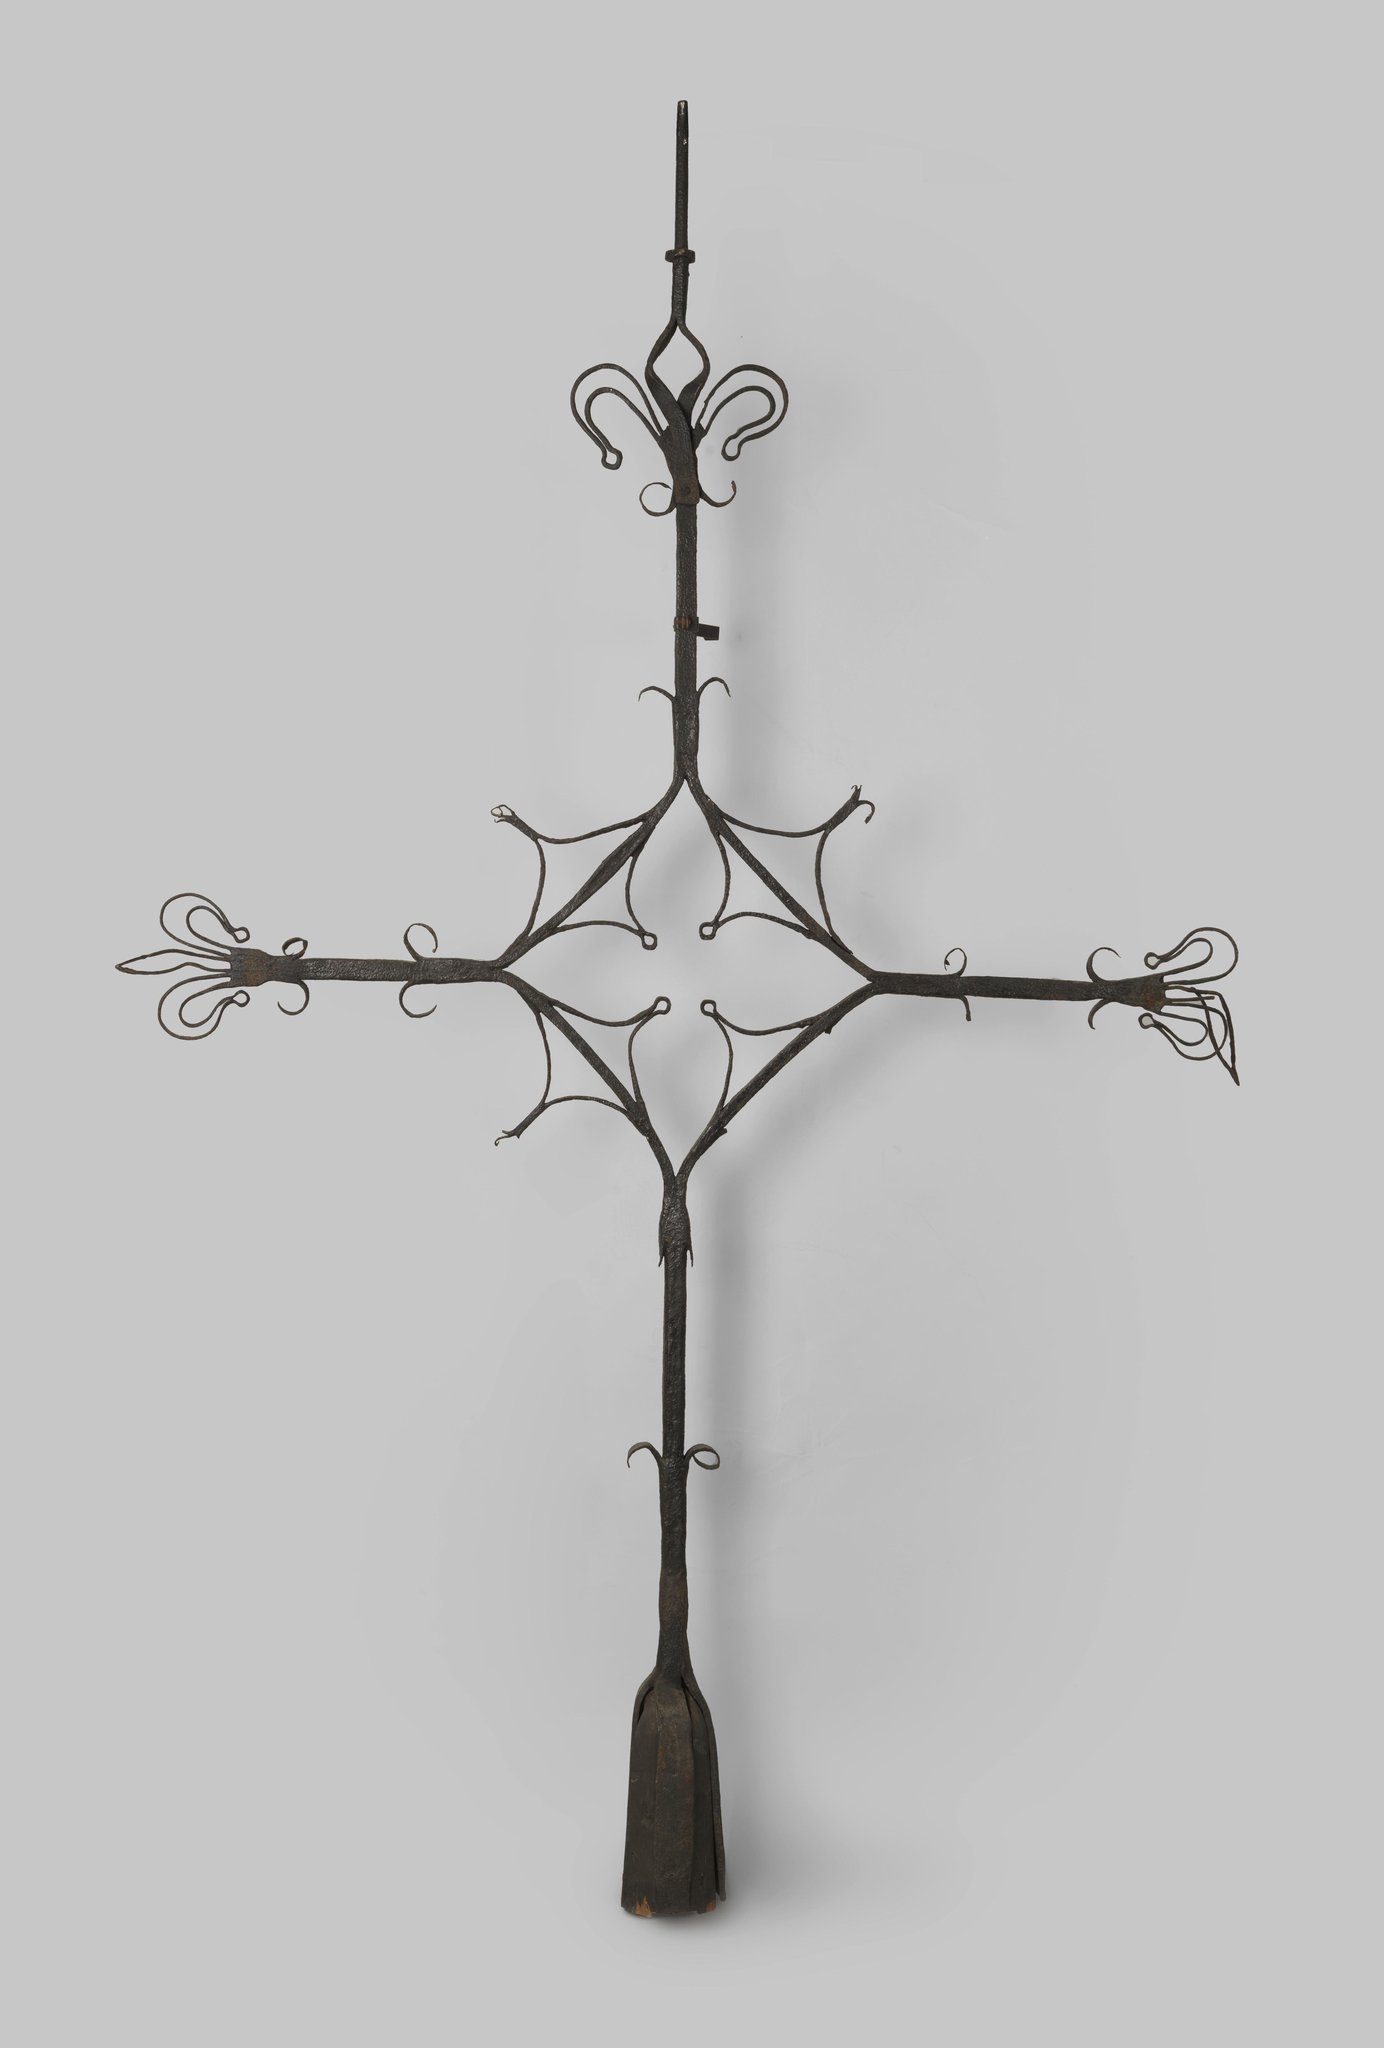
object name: torenkruis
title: Torenkruis, afkomstig van de NH Kerk te Geertruidenberg.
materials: iron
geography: geertruidenberg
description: Een gesmeed ijzeren kruis afkomstig van de toren van de hervormde kerk te Geertruidenberg.